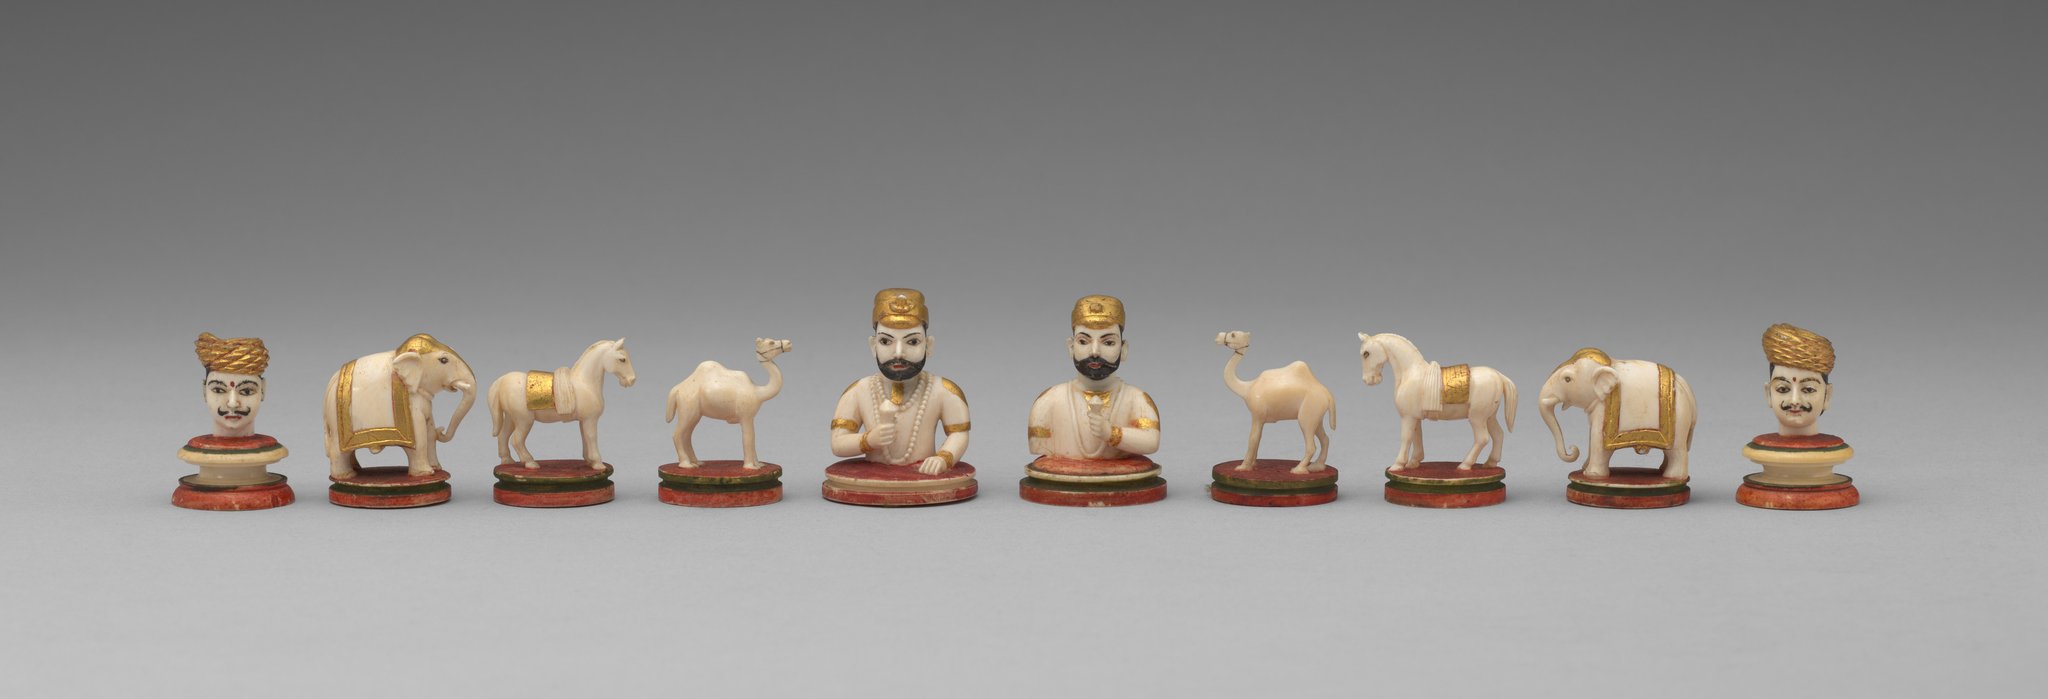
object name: chessman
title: Chessmen (32)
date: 1801-1900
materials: ivory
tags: chess,games